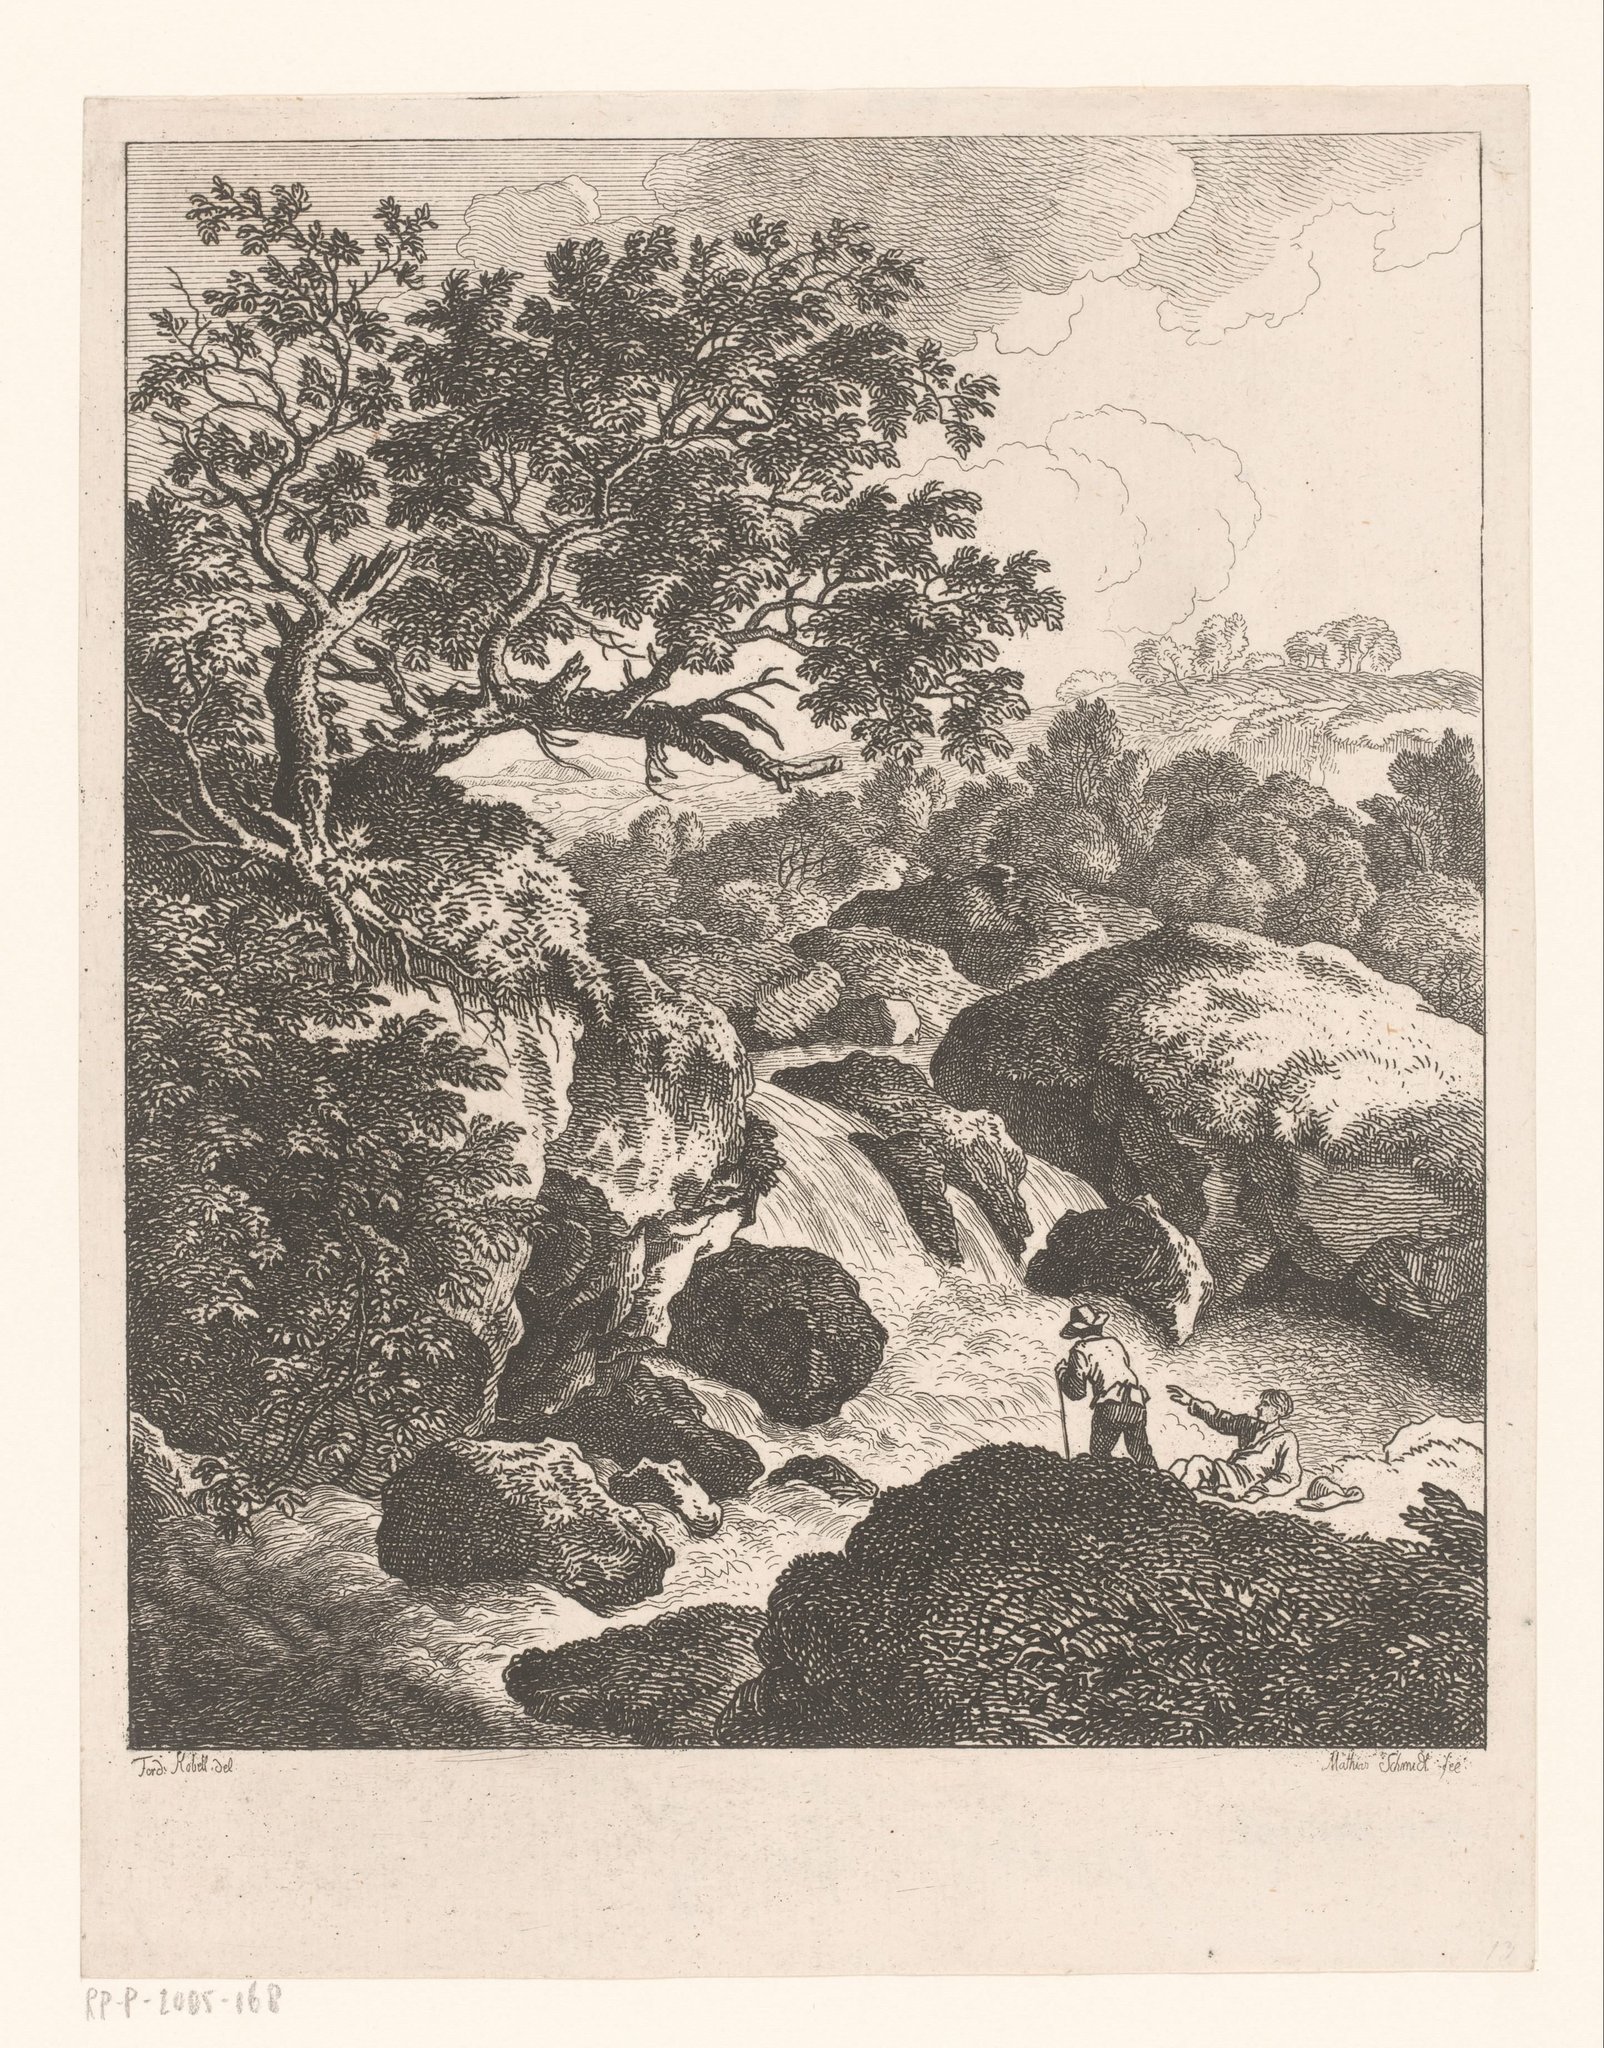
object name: print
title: Landschap met waterval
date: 1750-1799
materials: paper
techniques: etching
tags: waterfall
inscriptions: collector's mark: Lugt 2760, collector's mark: Lugt 2228